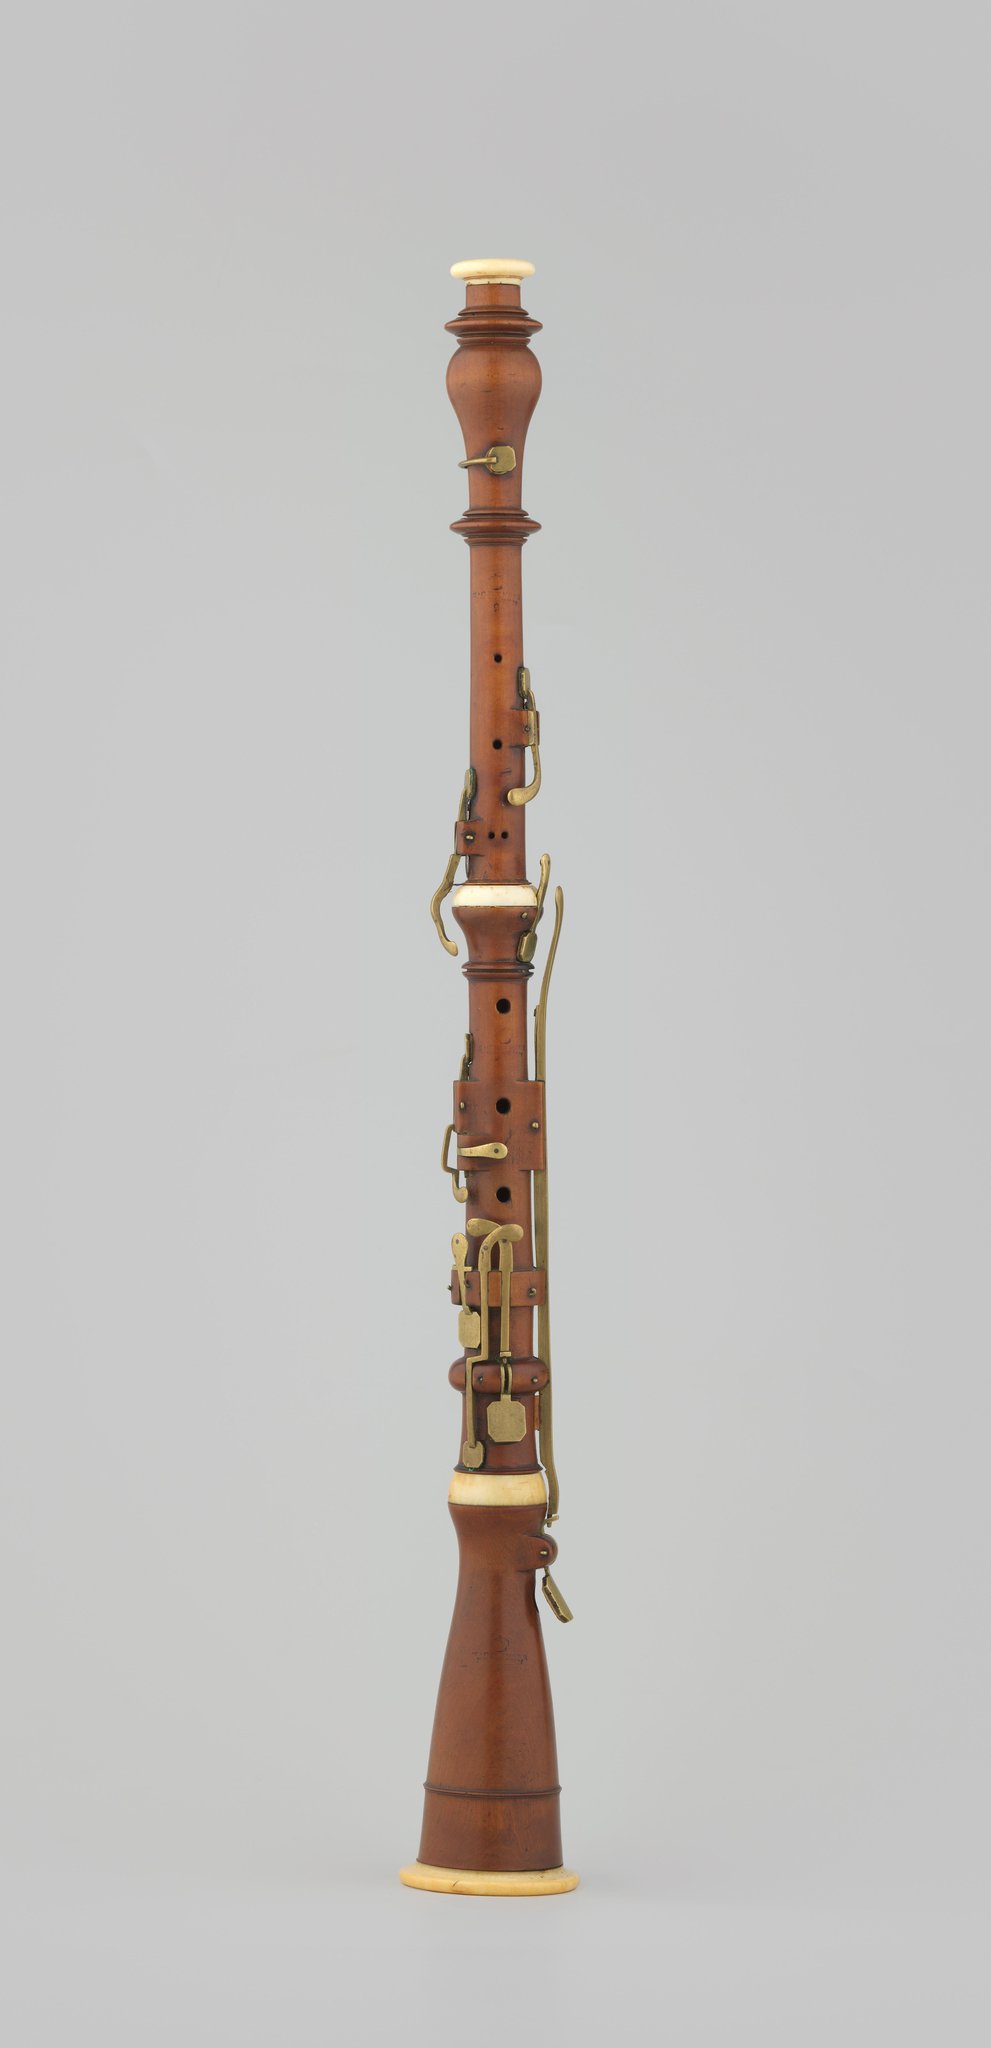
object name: oboe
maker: johann heinrich wihelm grenser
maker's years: 1753-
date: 1820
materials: wood, brass, ivory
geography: dresden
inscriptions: inscription: ‘kroon] / H. GRENSER / DRESDEN / 2’, inscription: ‘[kroon] / H. GRENSER / DRESDEN’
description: Hobo van palmhout met vier ivoren ringen en tien messing kleppen met achthoekige plaatjes. Het derde gat is dubbel. De vingersteun is uit het instrument gesneden. Gemarkeerd op het bovenste gedeelte: [kroon] / H. GRENSER / DRESDEN / 2. Gemarkeerd op de middelste en onderste gedeelte: [kroon] / H. GRENSER / DRESDEN.